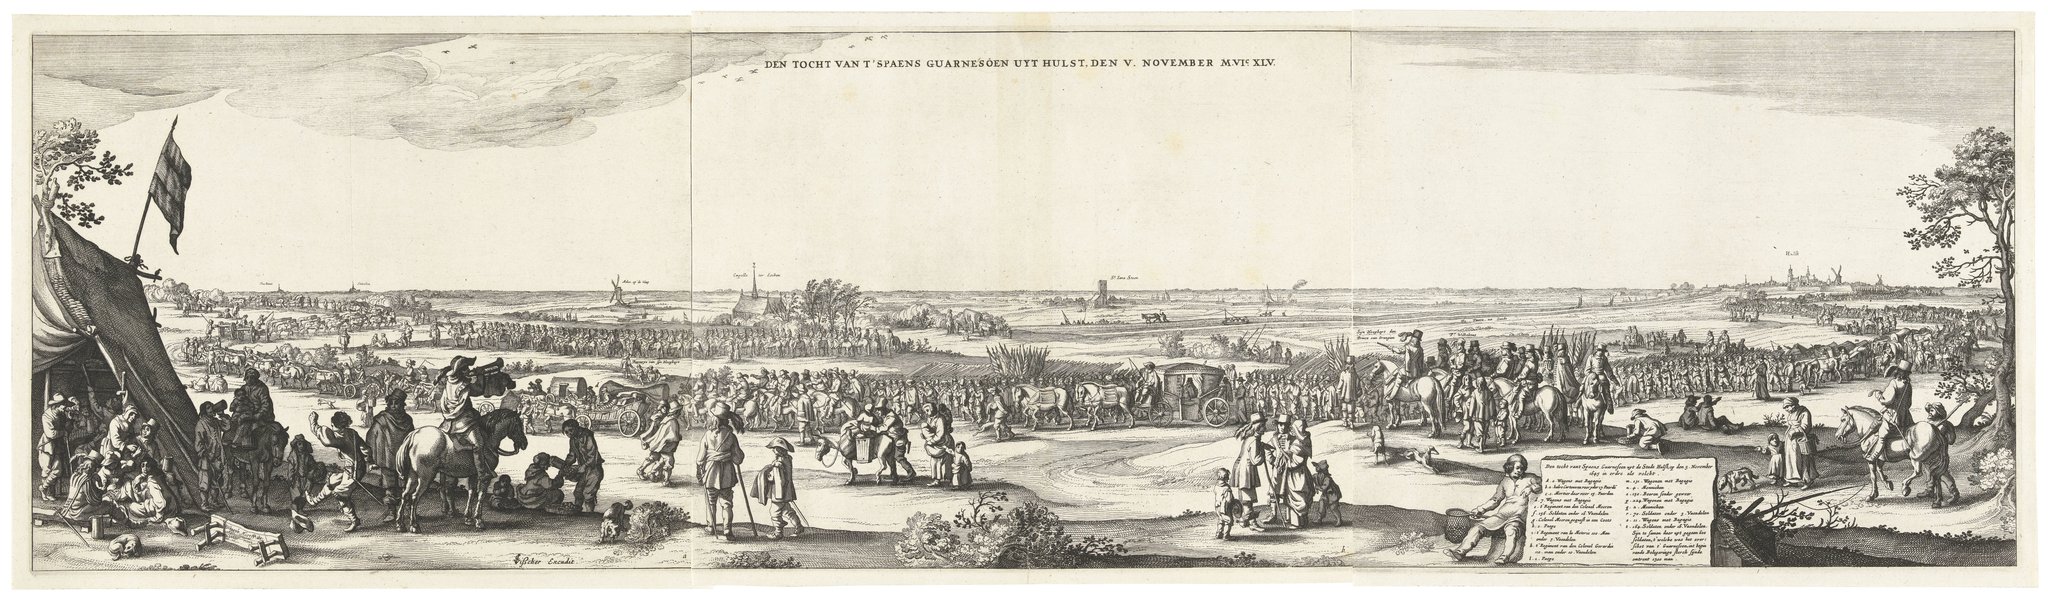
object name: print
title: Den tocht van t' Spaens guarnesoen uyt Hulst, den V. November MVICXLV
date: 1645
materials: paper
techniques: etching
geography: amsterdam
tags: delft, the hague, frederick henry (prince of orange), william ii (prince of orange), recreation ~ the soldier off duty, retreat of the defeated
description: Uittocht van het Spaanse garnizoen uit Hulst, 1645. Hulst, belegerd door het Staatse leger onder Frederik Hendrik vanaf 28 september en ingenomen op 5 november 1645. Voorstelling bestaande uit drie bladen. Op de voorgrond Staatse soldaten, op de achtergrond de stoet met goederenwagens, voetsoldaten en ruiters. Wellicht onderdeel van een ongemonteerd ensemble bestaande uit de twee kaarten, het profiel, het blad met de zes forten, de drie bladen van de uittocht van het garnizoen en de twee tekstbladen.